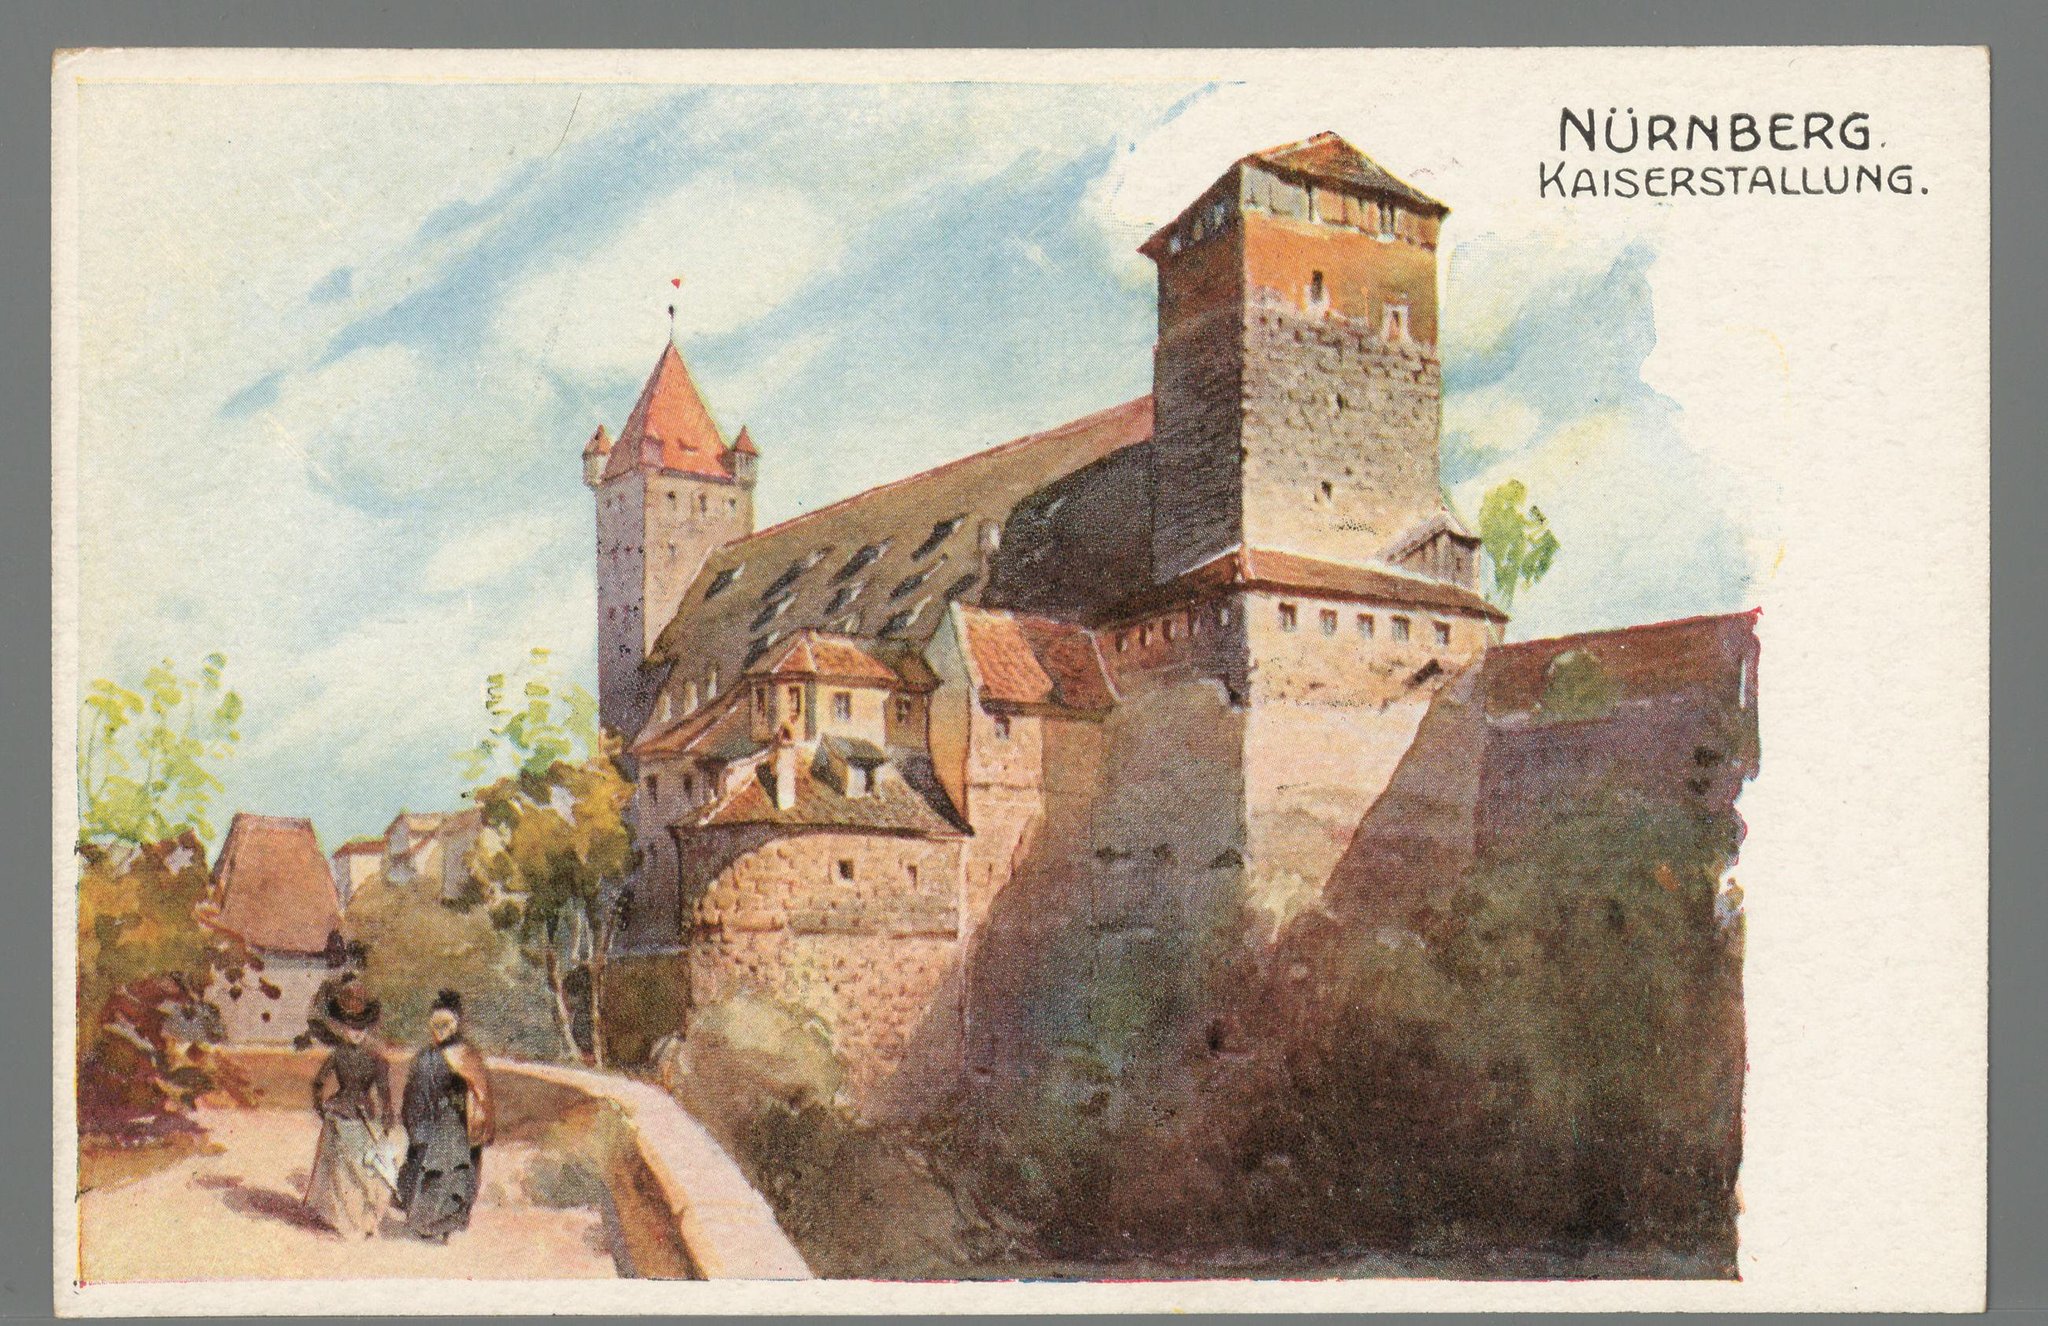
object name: photomechanical print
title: Nürnberg. Kaiserstallung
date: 1905-1930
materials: cardboard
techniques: color autotype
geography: nuremberg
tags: castle, stall, stable